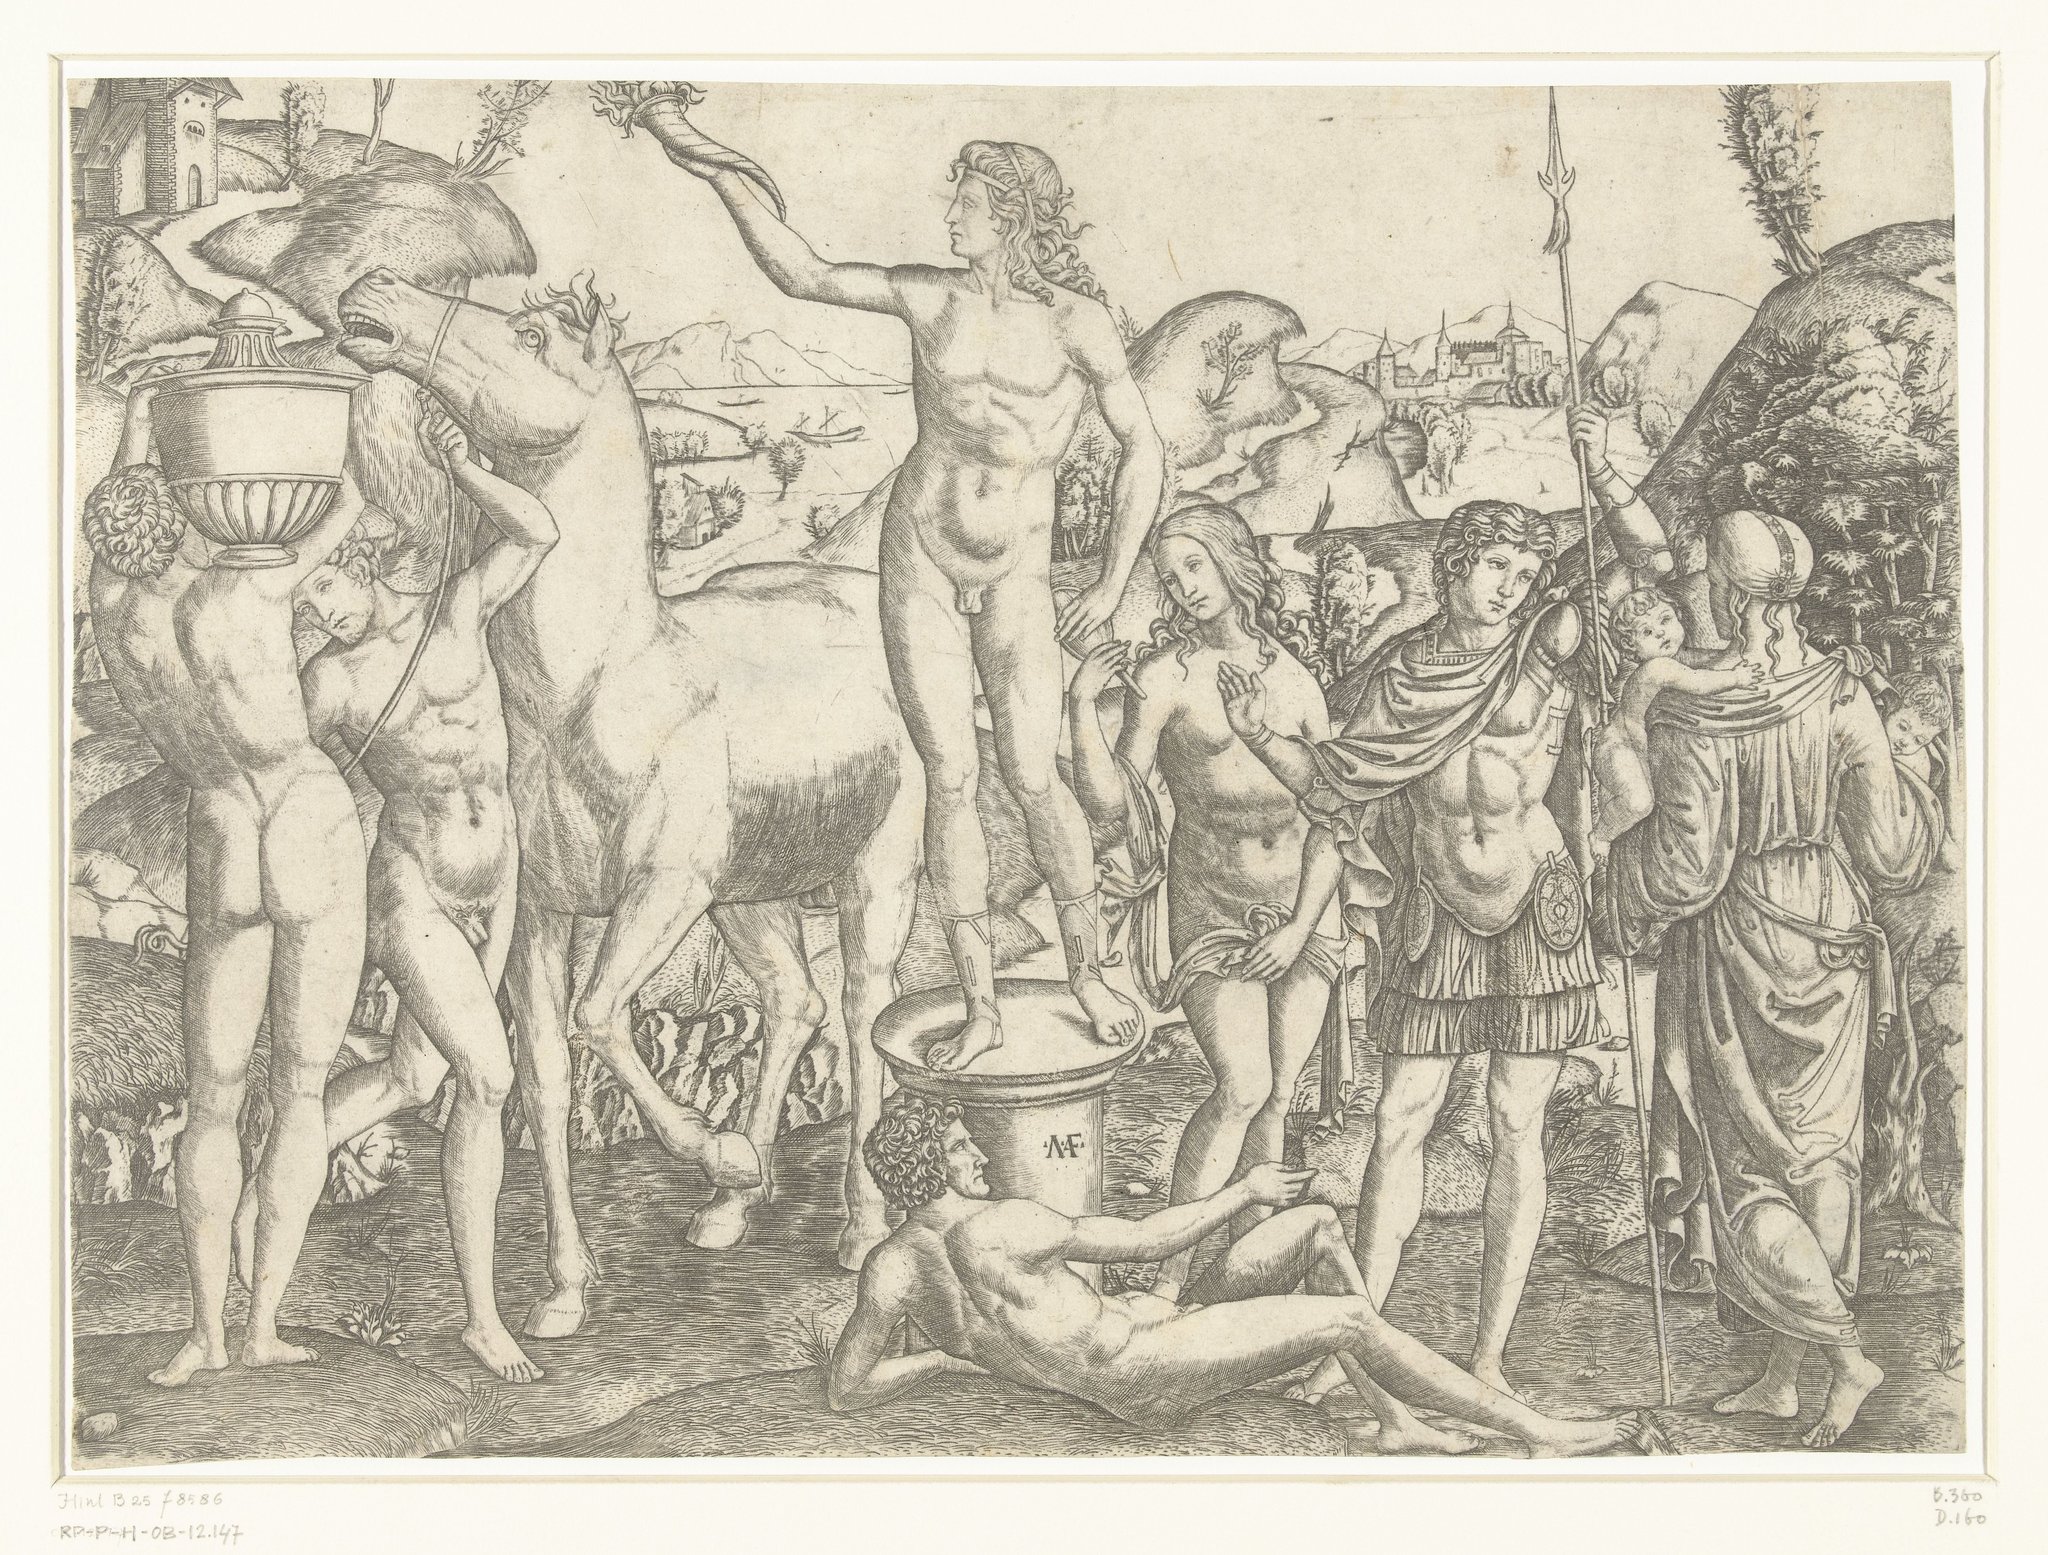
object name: print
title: Naakte man met fakkel staat op sokkel omringd door naakte mannen met paard en vaas en soldaat geflankeerd door deugden Voorzichtigheid en Liefde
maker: marcantonio raimondi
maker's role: print maker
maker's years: 1470-1534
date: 1510-1527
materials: paper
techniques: engraving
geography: italy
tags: charity, 'caritas'; 'carità' (ripa) ~ one of the three theological virtues, prudence, 'prudentia'; 'prudenza' (ripa) ~ one of the four cardinal virtues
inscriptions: inscription: ‘B 25 f 85 86’, collector's mark: Lugt 10, collector's mark: Lugt 11